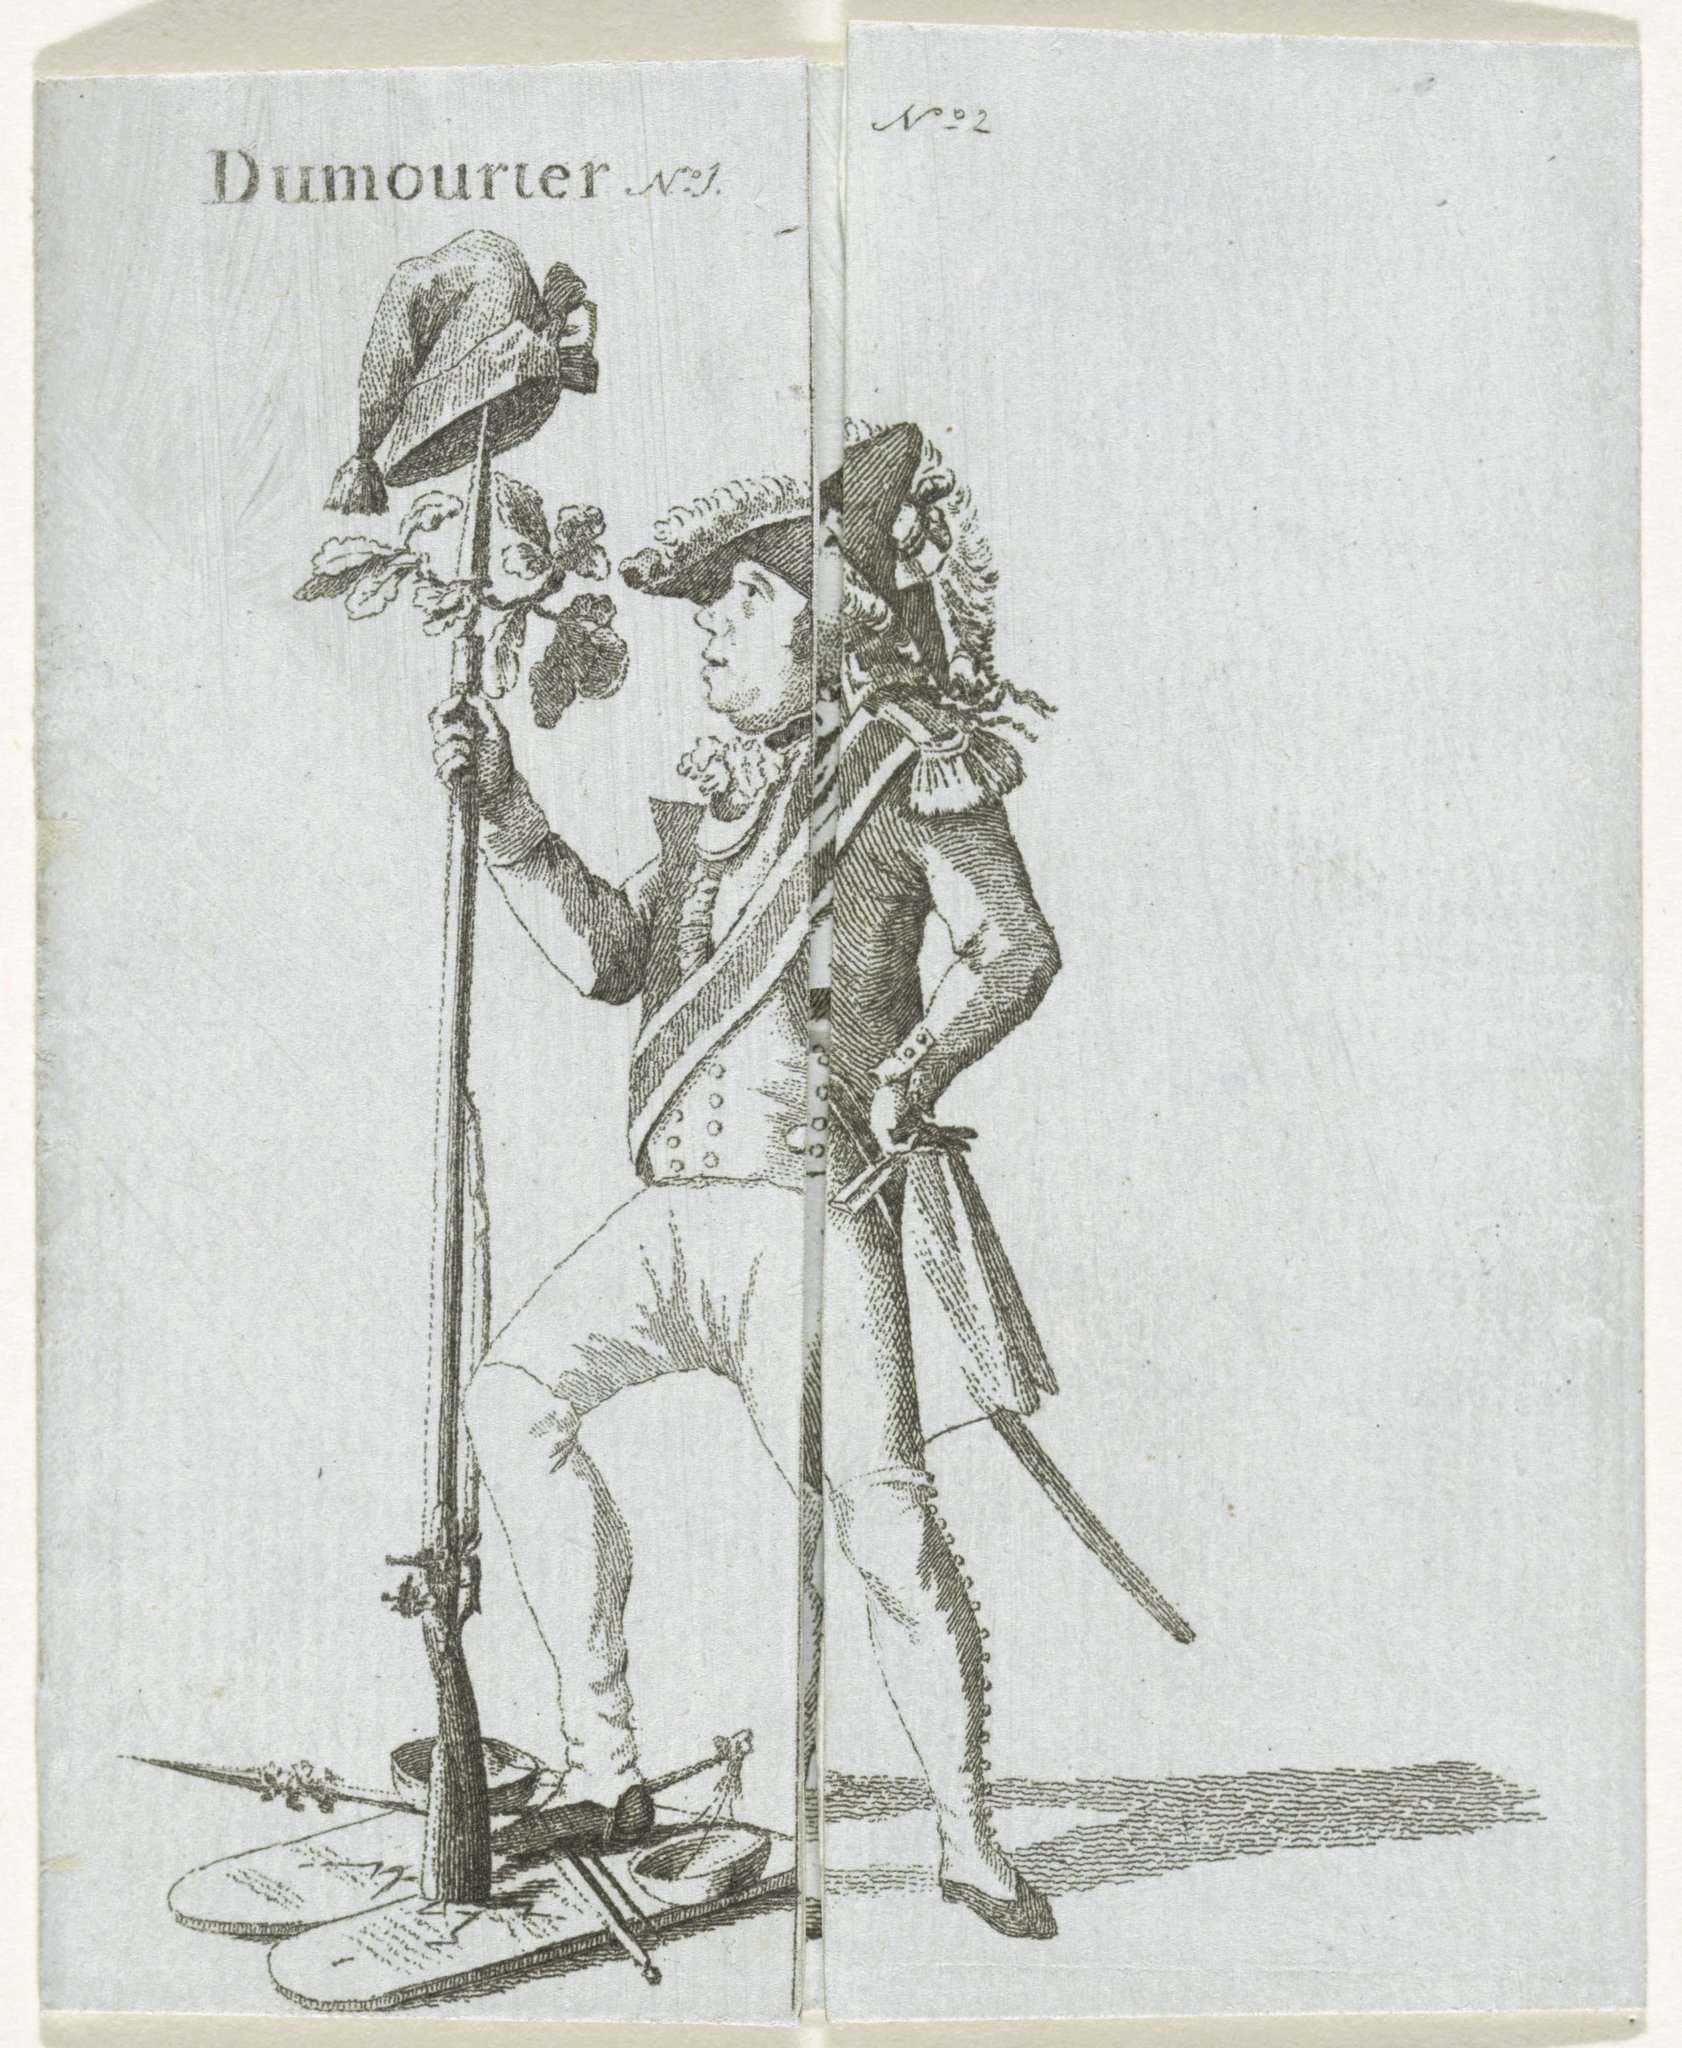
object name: print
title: Dumourier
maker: Anonymous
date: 1793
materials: paper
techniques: etching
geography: northern netherlands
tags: devil(s) and demons, france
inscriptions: collector's mark: Lugt 2228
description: Spotprent op de val van generaal Charles François Dumouriez, waarbij met het openvouwen van bladen de voorstelling vier keer verandert. Begint aan de buitenzijde met Dumouriez staande met een geweer met jacobijnenmuts geplant op de wetstafelen en eindigt binnenin met een voorstelling waarin de generaal door een duivel in de hel wordt gegooid. Bij de prent behoort een tekstblad.